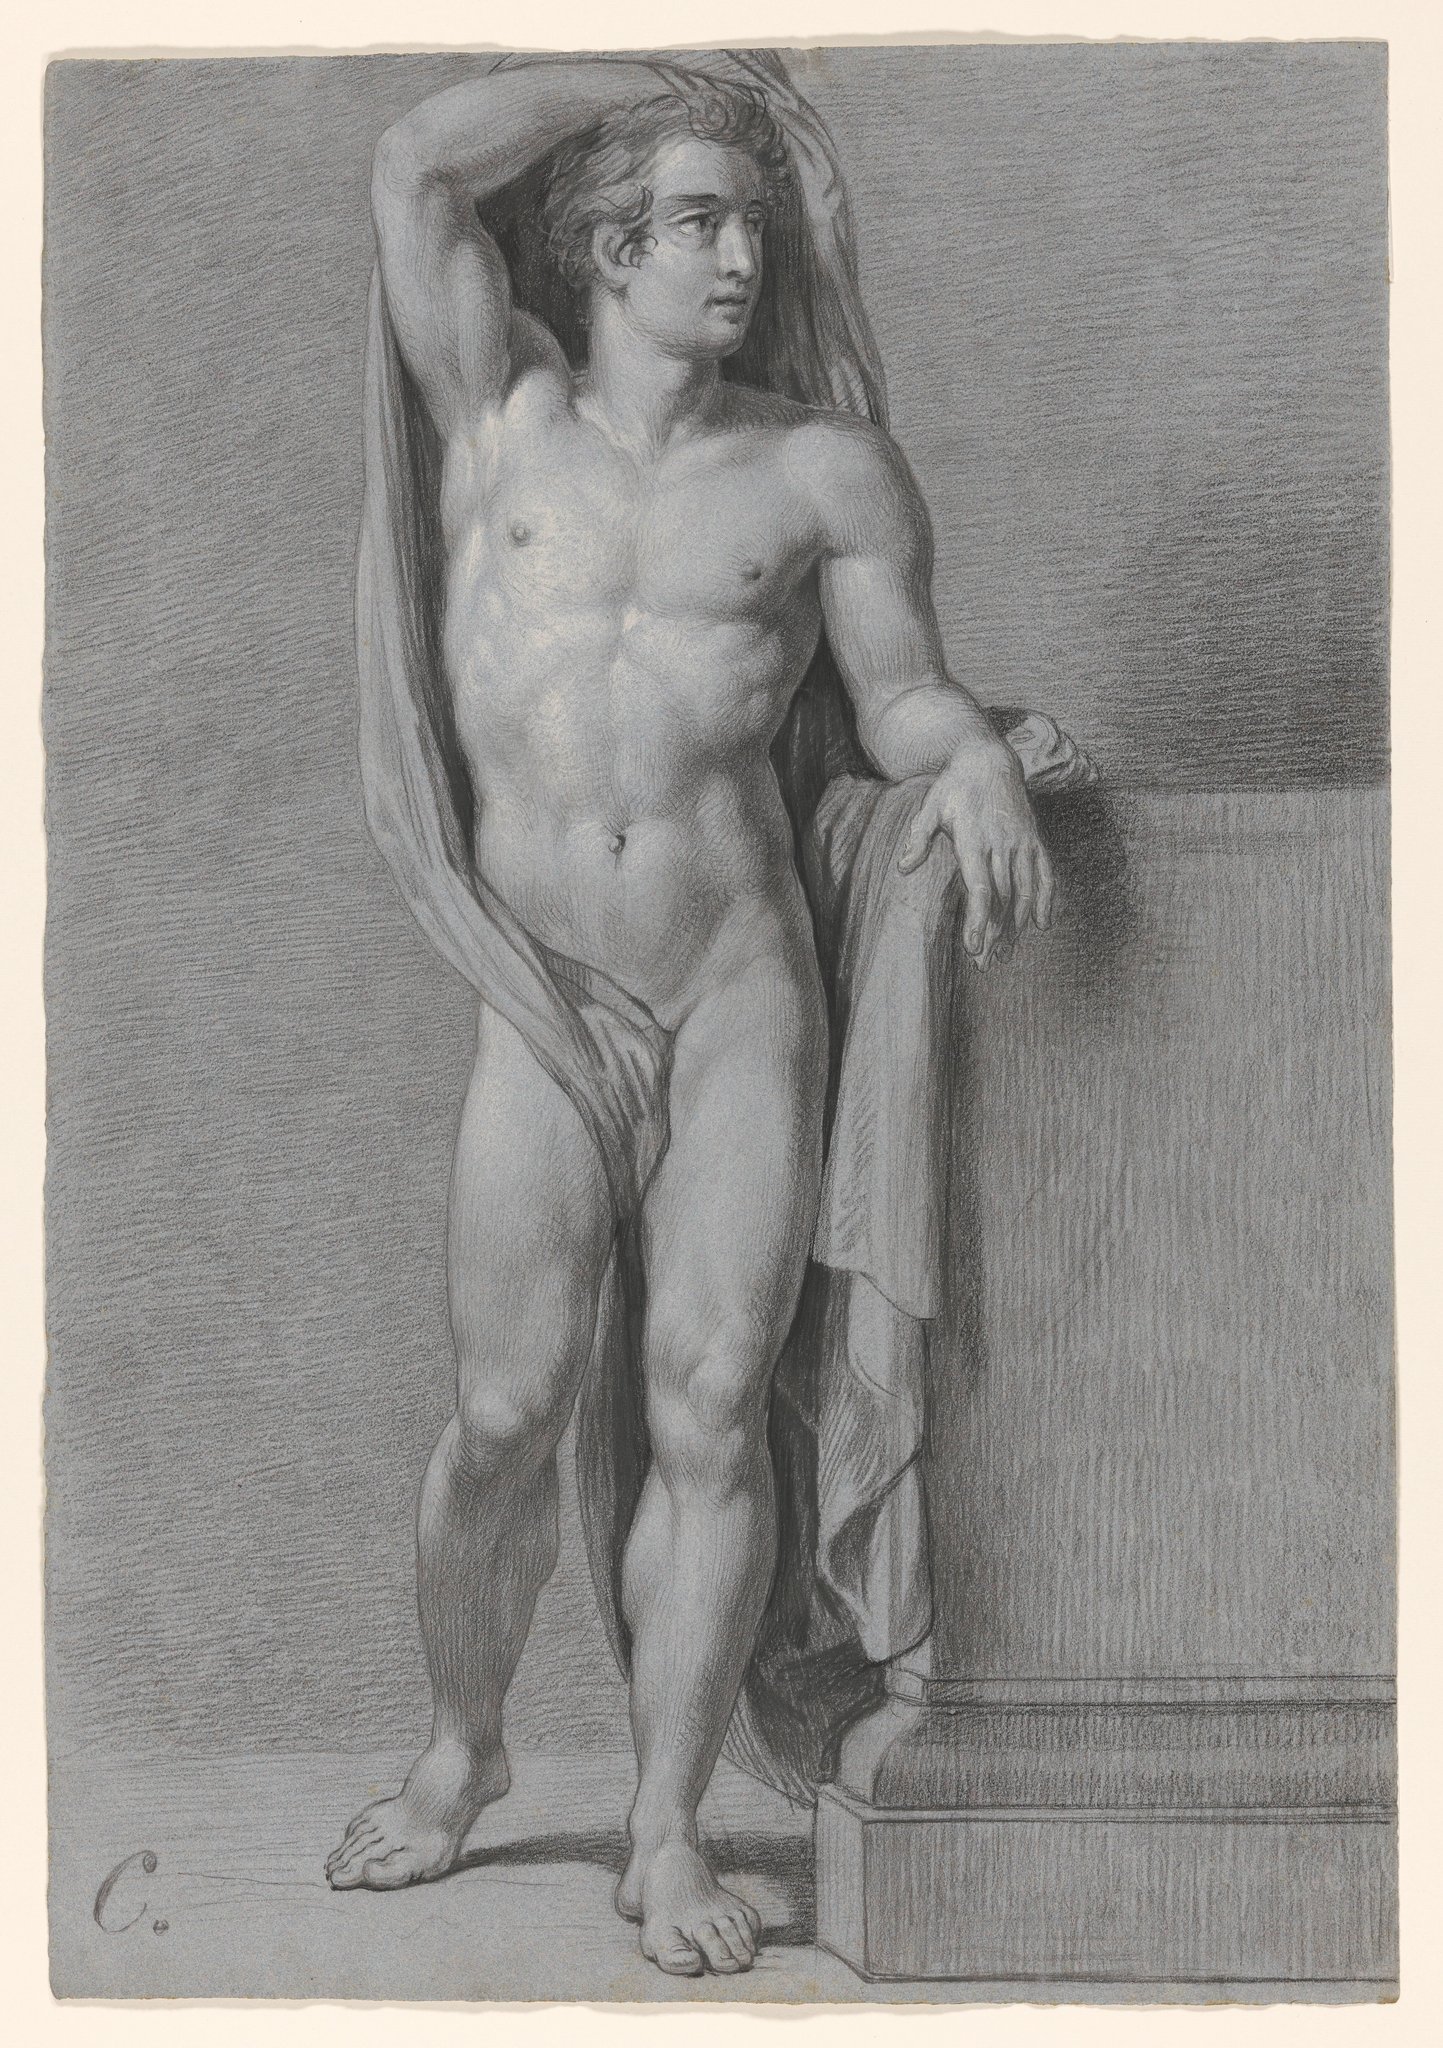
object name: drawing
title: Staand mannelijk naakt, van voren gezien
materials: chalk, paper